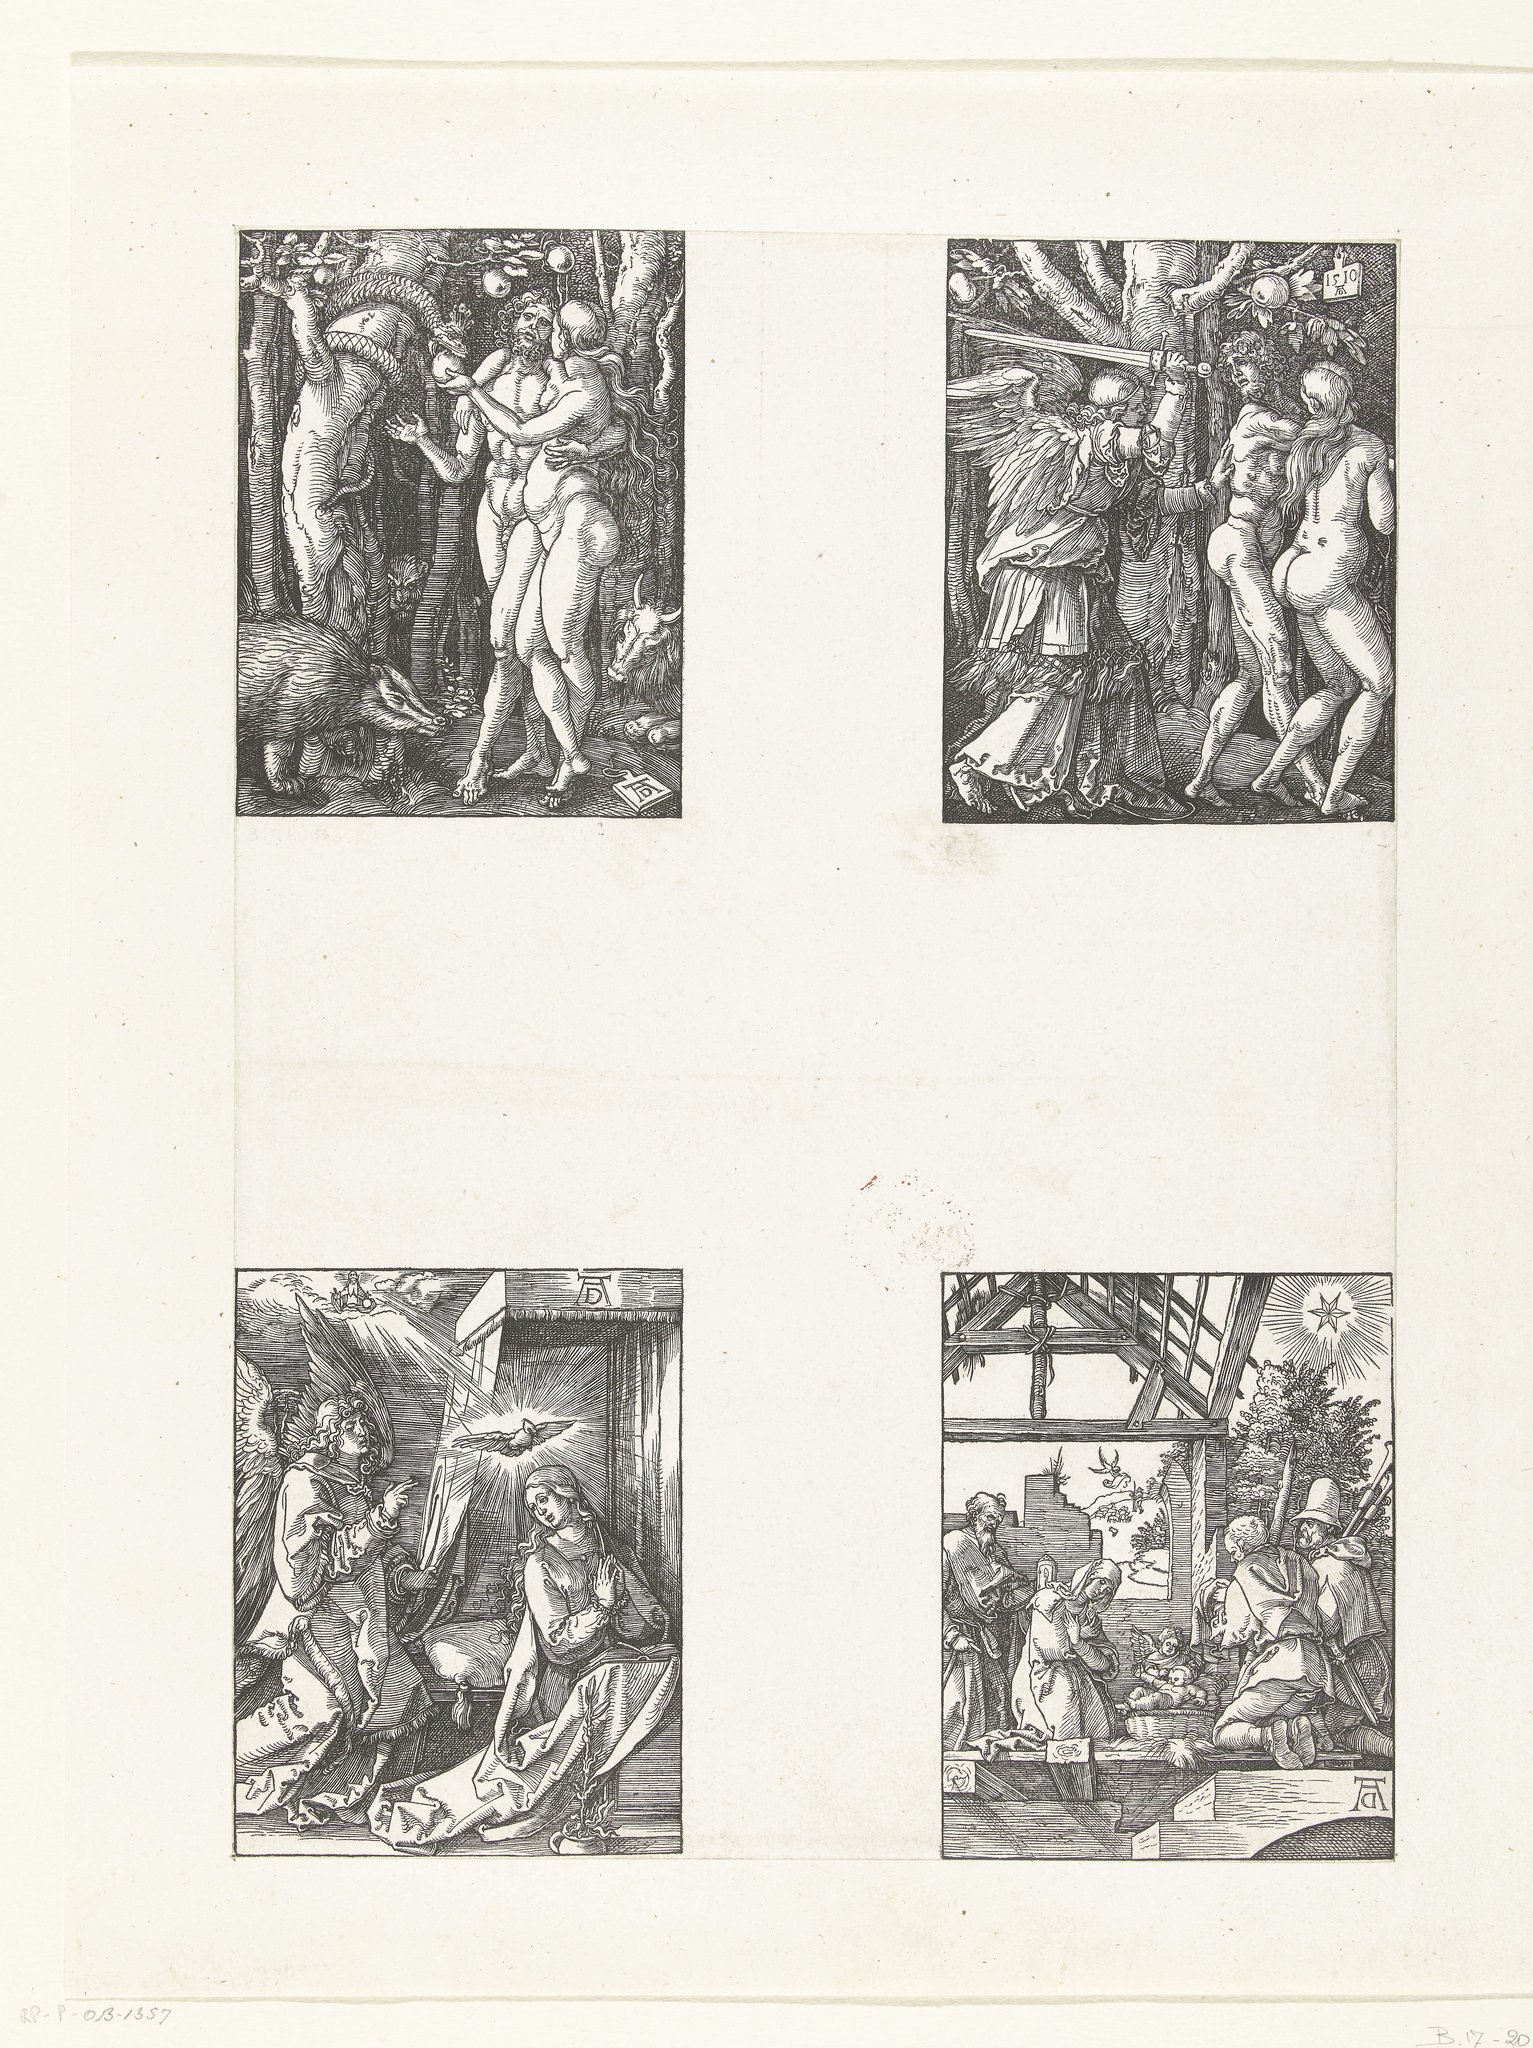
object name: print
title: Zondeval, Adam en Eva verdreven uit het paradijs, Annunciatie, Aanbidding der herders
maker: albrecht dürer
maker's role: draughtsman, painter, print maker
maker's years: 1471-1528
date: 1510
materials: paper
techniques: woodcut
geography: nuremberg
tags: adoration of the christ-child by the shepherds; mary and joseph present, the annunciation: mary kneeling, an angel chases adam and eve out of paradise with a (flaming) sword, eve takes the fruit from the serpent (or the tree) in the presence of adam (who may be trying to stop her)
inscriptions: collector's mark: Lugt 240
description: De eerste reeks van vier scènes uit de prentserie 'De kleine Passie', hier nog onversneden met 4 afbeeldingen op 1 blad. Linksboven: Eva neemt de vrucht van de slang aan. Rechtsboven: Adam en Eva worden verdreven uit het paradijs. Linksonder: De engel Gabriël kondigt de geboorte van Christus bij Maria aan. Rechtsonder: Maria, Jozef en enkele herders aanbidden het Christuskind in een vervallen stal.